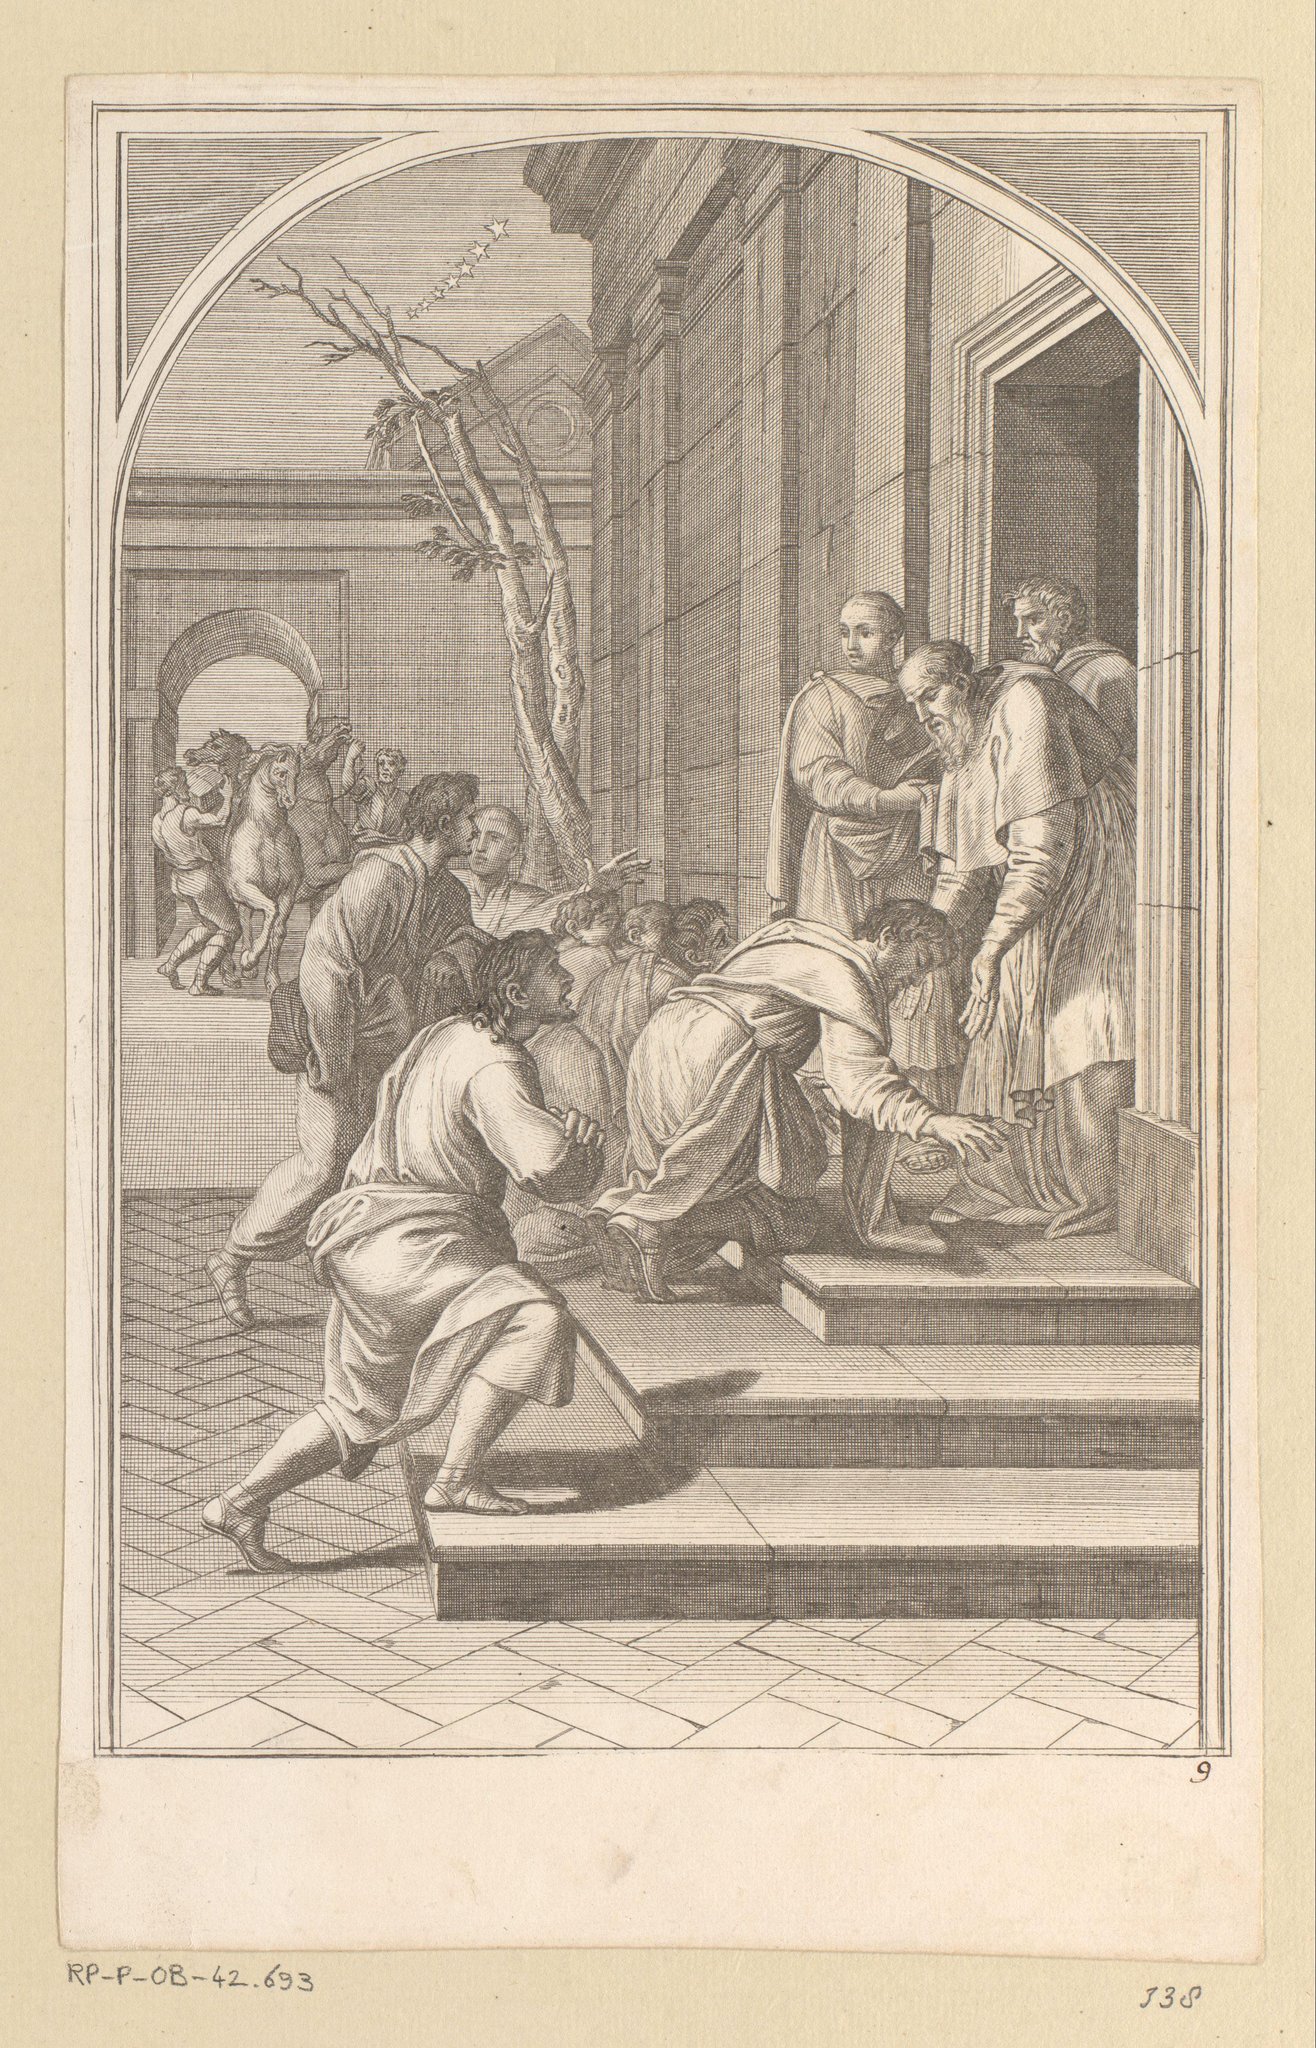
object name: print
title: Aankomst van de Heilige Bruno en zijn volgelingen in Grenoble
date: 1623-1676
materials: paper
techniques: printmaking, engraving, etching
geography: france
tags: the founder of the order of the carthusians, bruno; possible attributes: cross, finger at lips, lily, mitre at his feet, olive-branch, ray of light, skull, (seven) star(s)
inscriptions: collector's mark: Lugt 2165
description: Maakt deel uit van een serie met 24 prenten (inclusief twee titelprenten), naar schilderijen door Lesueur vervaardigd tussen 1645-1648 voor de Chartreuse de Paris. De serie is getiteld: La vie de St. Bruno fondateur de l'Ordre des Chartreux peinte au cloistre de la Chartreuse de Paris par Eustache Le Sueur.